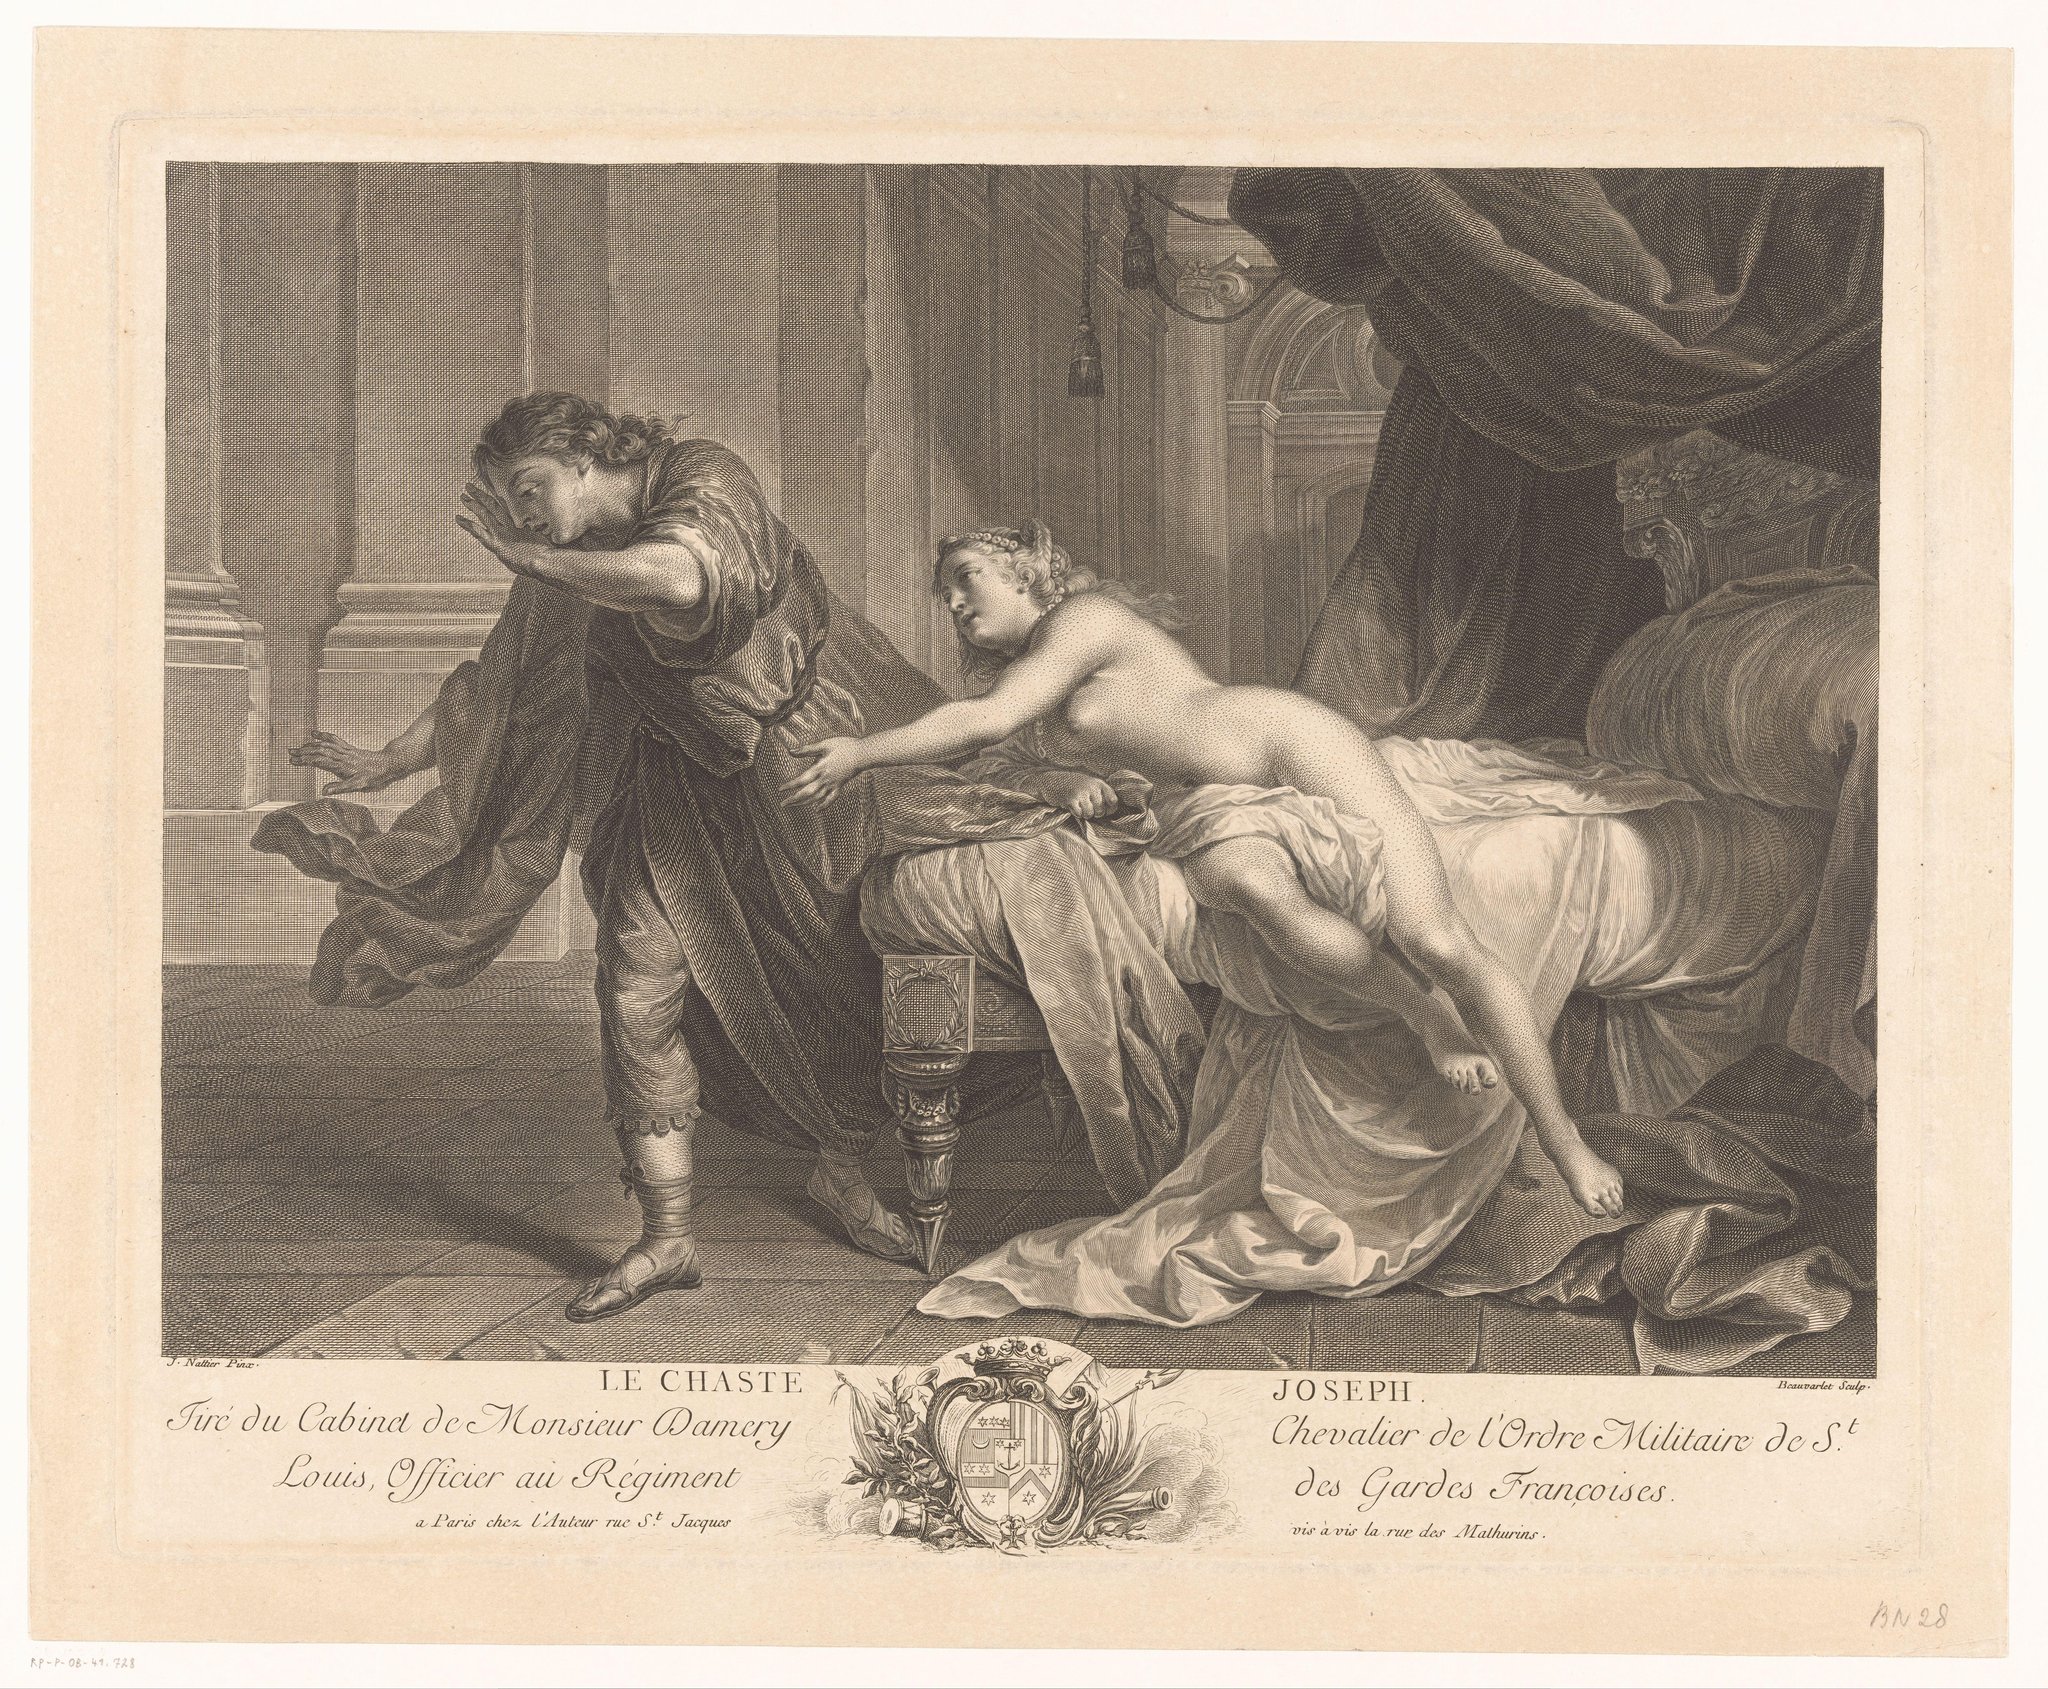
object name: print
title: Jozef weerstaat de verleiding van Potifars vrouw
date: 1741-1797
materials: paper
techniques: engraving, etching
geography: paris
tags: joseph in potiphar's house; the chastity of joseph (genesis 37:36, 39:1-20), armorial bearing, heraldry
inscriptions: watermark, collector's mark: Lugt 2228